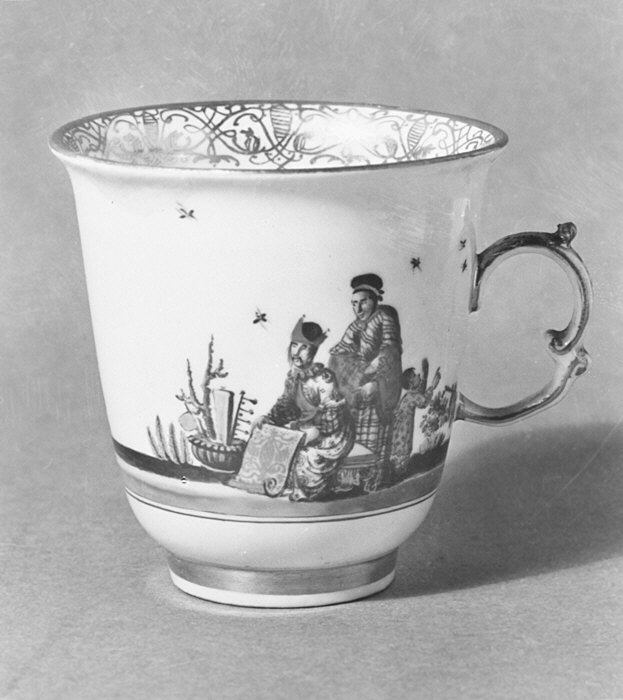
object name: cup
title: Cup (part of a set)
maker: meissen manufactory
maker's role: manufactory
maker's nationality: german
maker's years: 1710-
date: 1735-1740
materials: hard paste porcelain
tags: chinoiserie,men